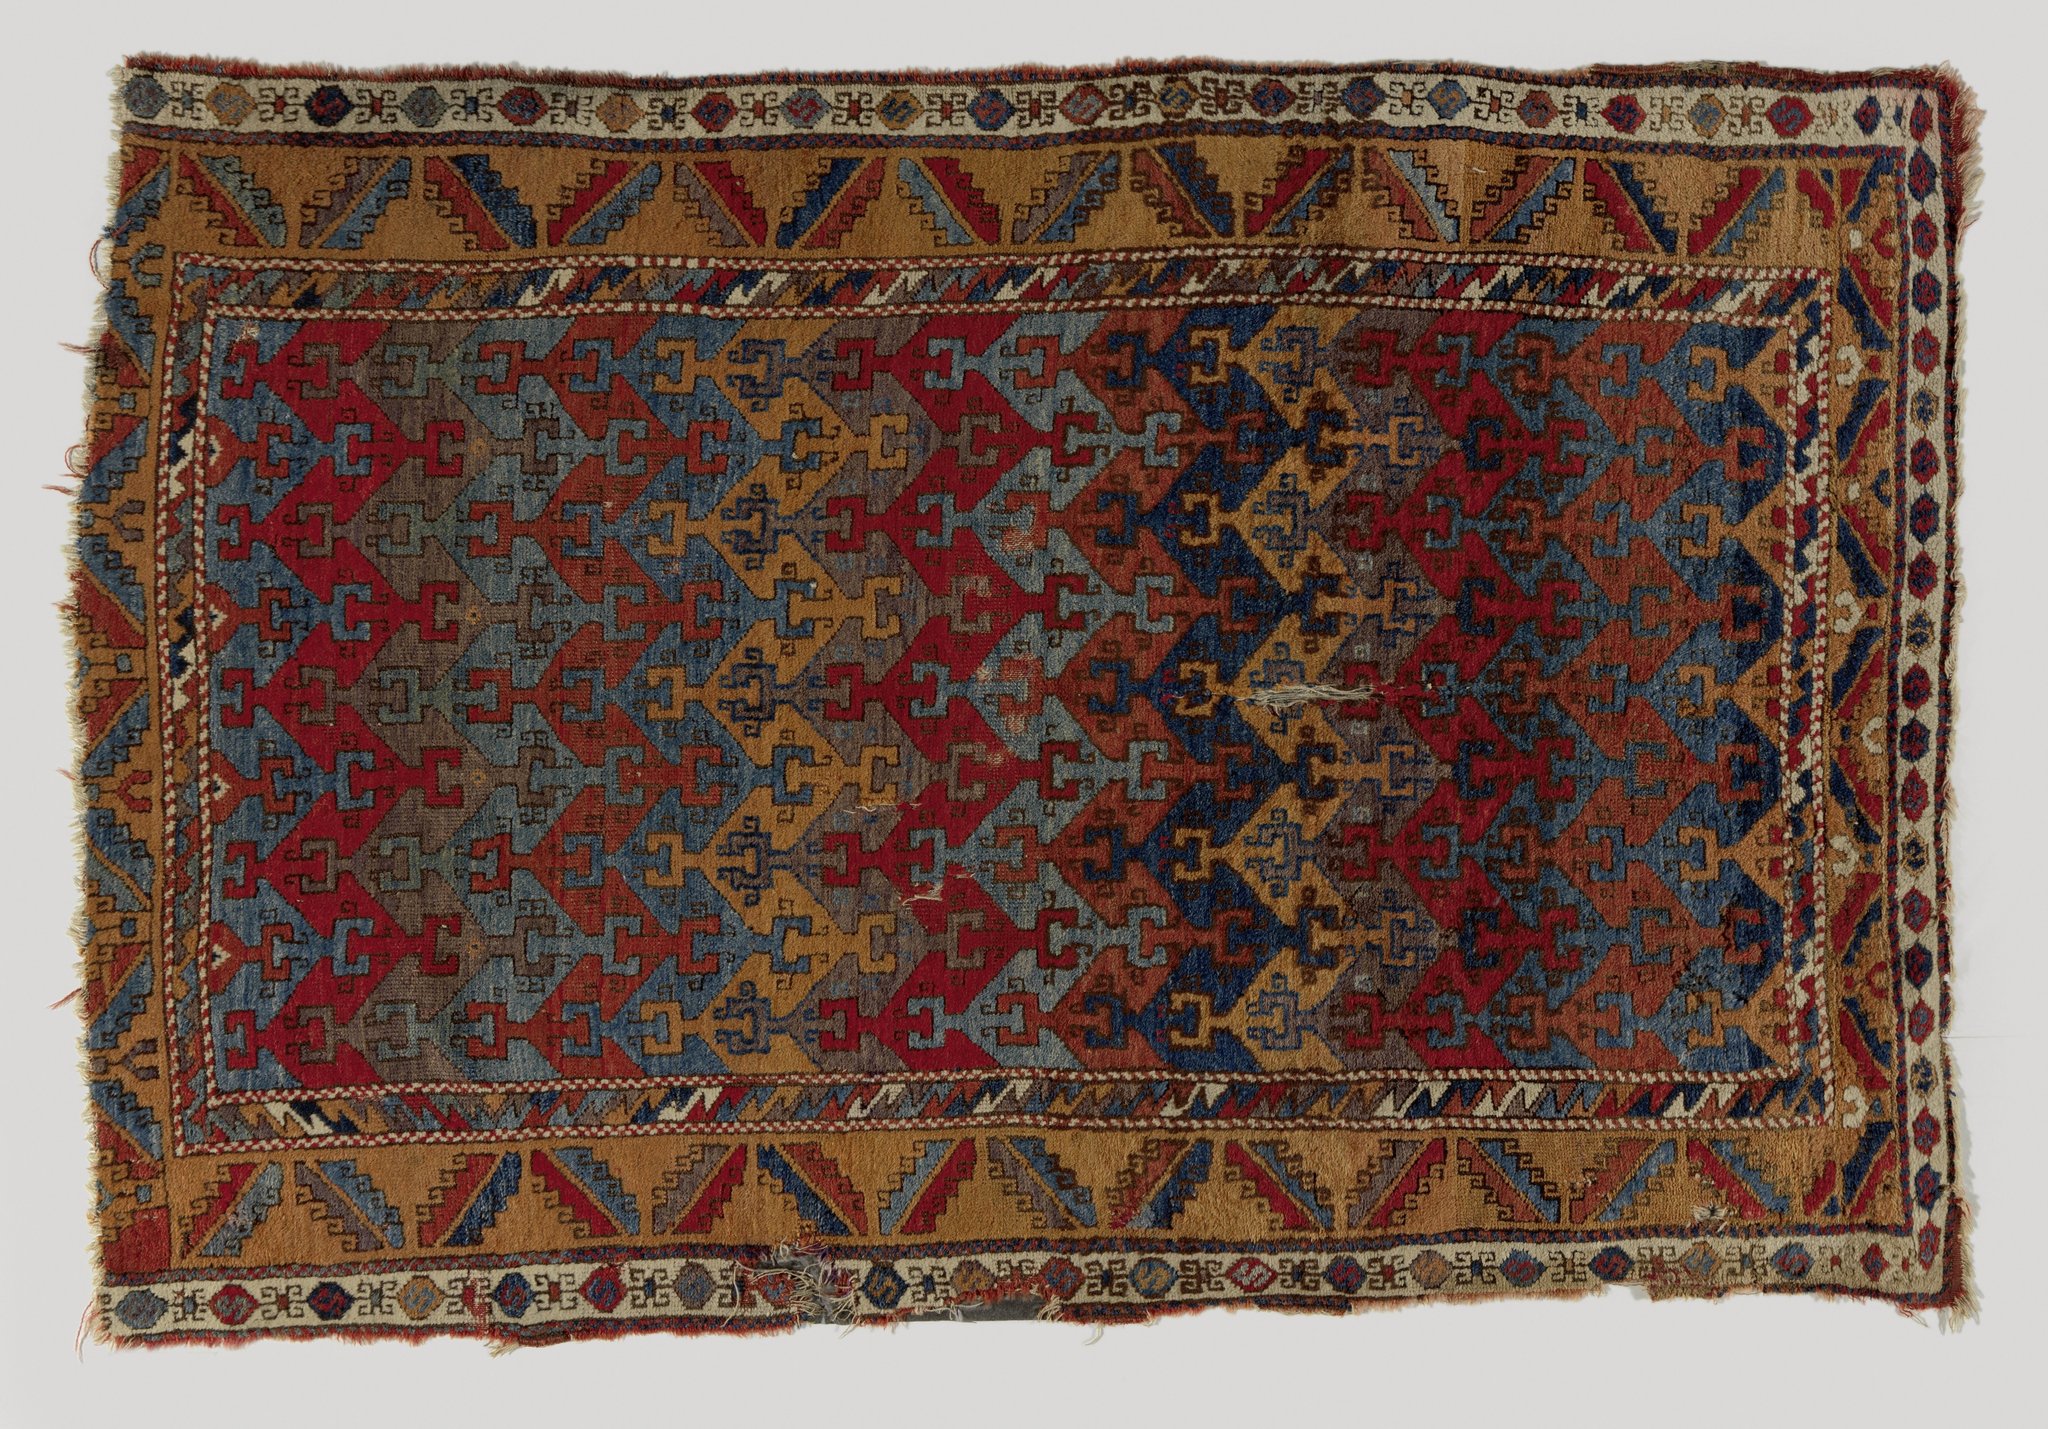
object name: oriental rug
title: Oosters tapijt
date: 1800-1815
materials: wool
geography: kazakhstan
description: Oosters tapijt, zigzagkleed. Middenveld met zigzagpatroon met haken. De breedste rand is versierd met hoekige bladeren in een zigzag-patroon.